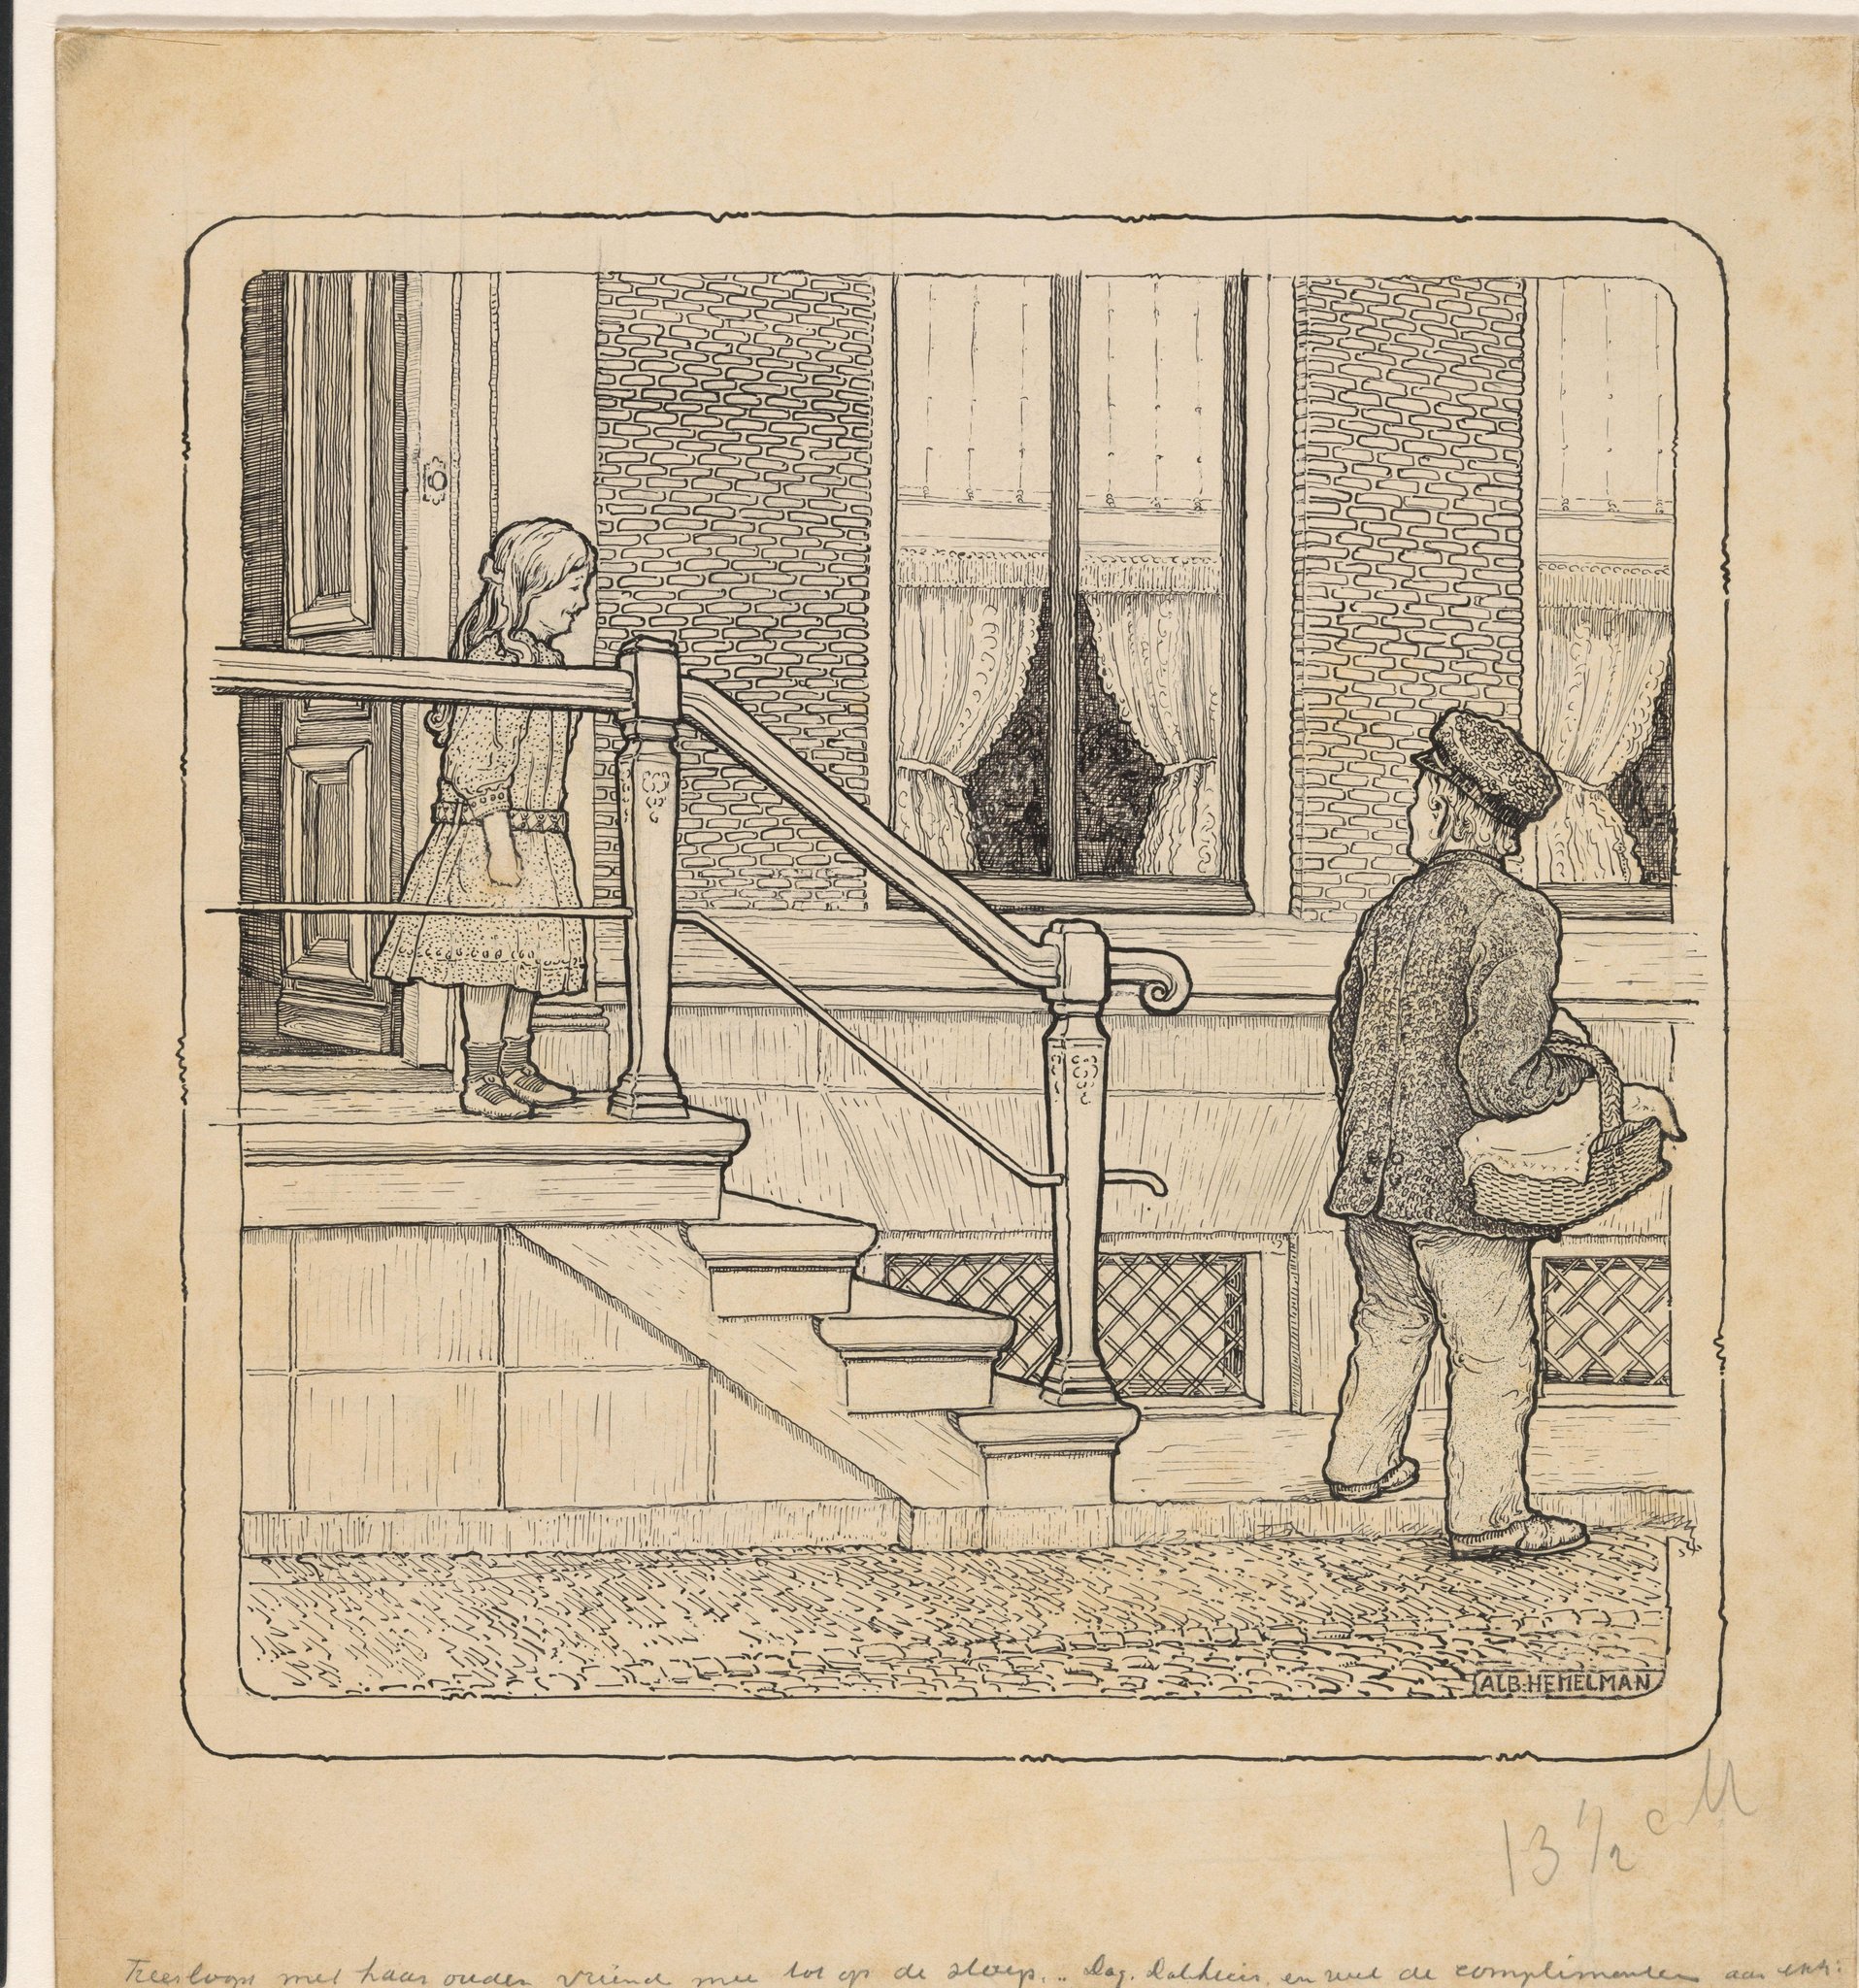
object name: drawing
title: Trees en Dakhuis voor een rijtjeshuis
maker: albert hemelman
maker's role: draughtsman, print maker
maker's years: 1883-1951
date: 1893-1951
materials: cardboard, ink, pencil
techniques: pen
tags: child, front steps, street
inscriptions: collector's mark: Lugt 2228, signature: ‘ALB. HEMELMAN’, annotation: ‘Trees loopt met haar ouden vriend mee tot op de stoep. "Dag, Dakhui, en wel de complimenten aan enz"’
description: Trees staat op een trap voor de open deur van een huis. Dakhuis loopt onderaan de trap weg over straat met een mand om zijn arm. Hij kijkt over zijn schouder naar Trees.